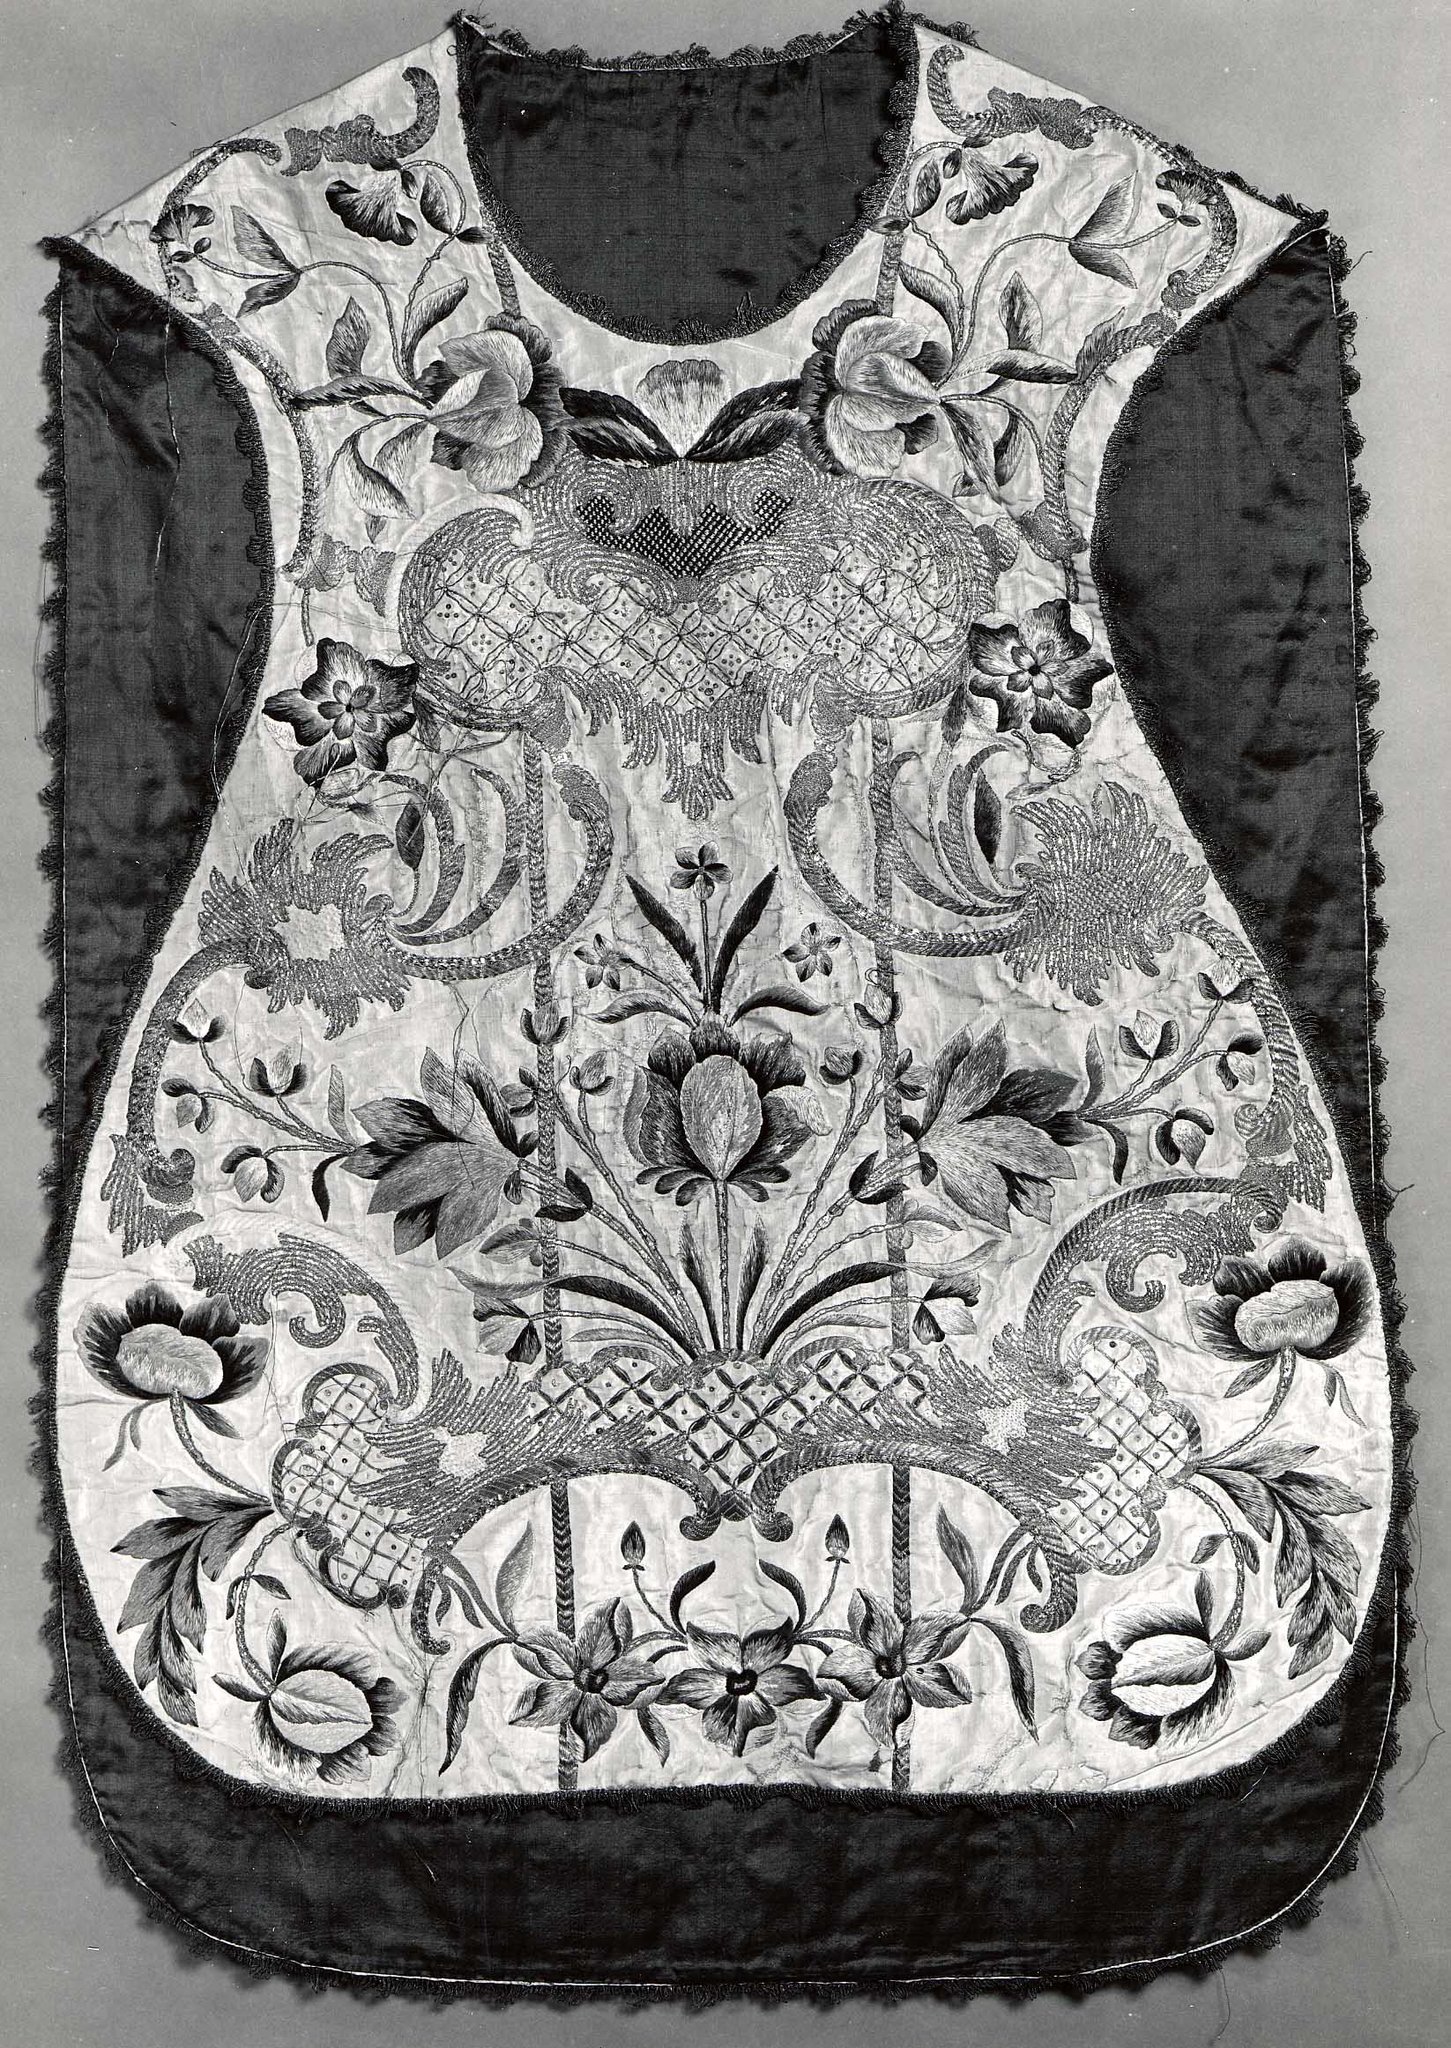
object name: chasuble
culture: italian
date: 1701-1800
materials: linen, metal, silk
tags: flowers